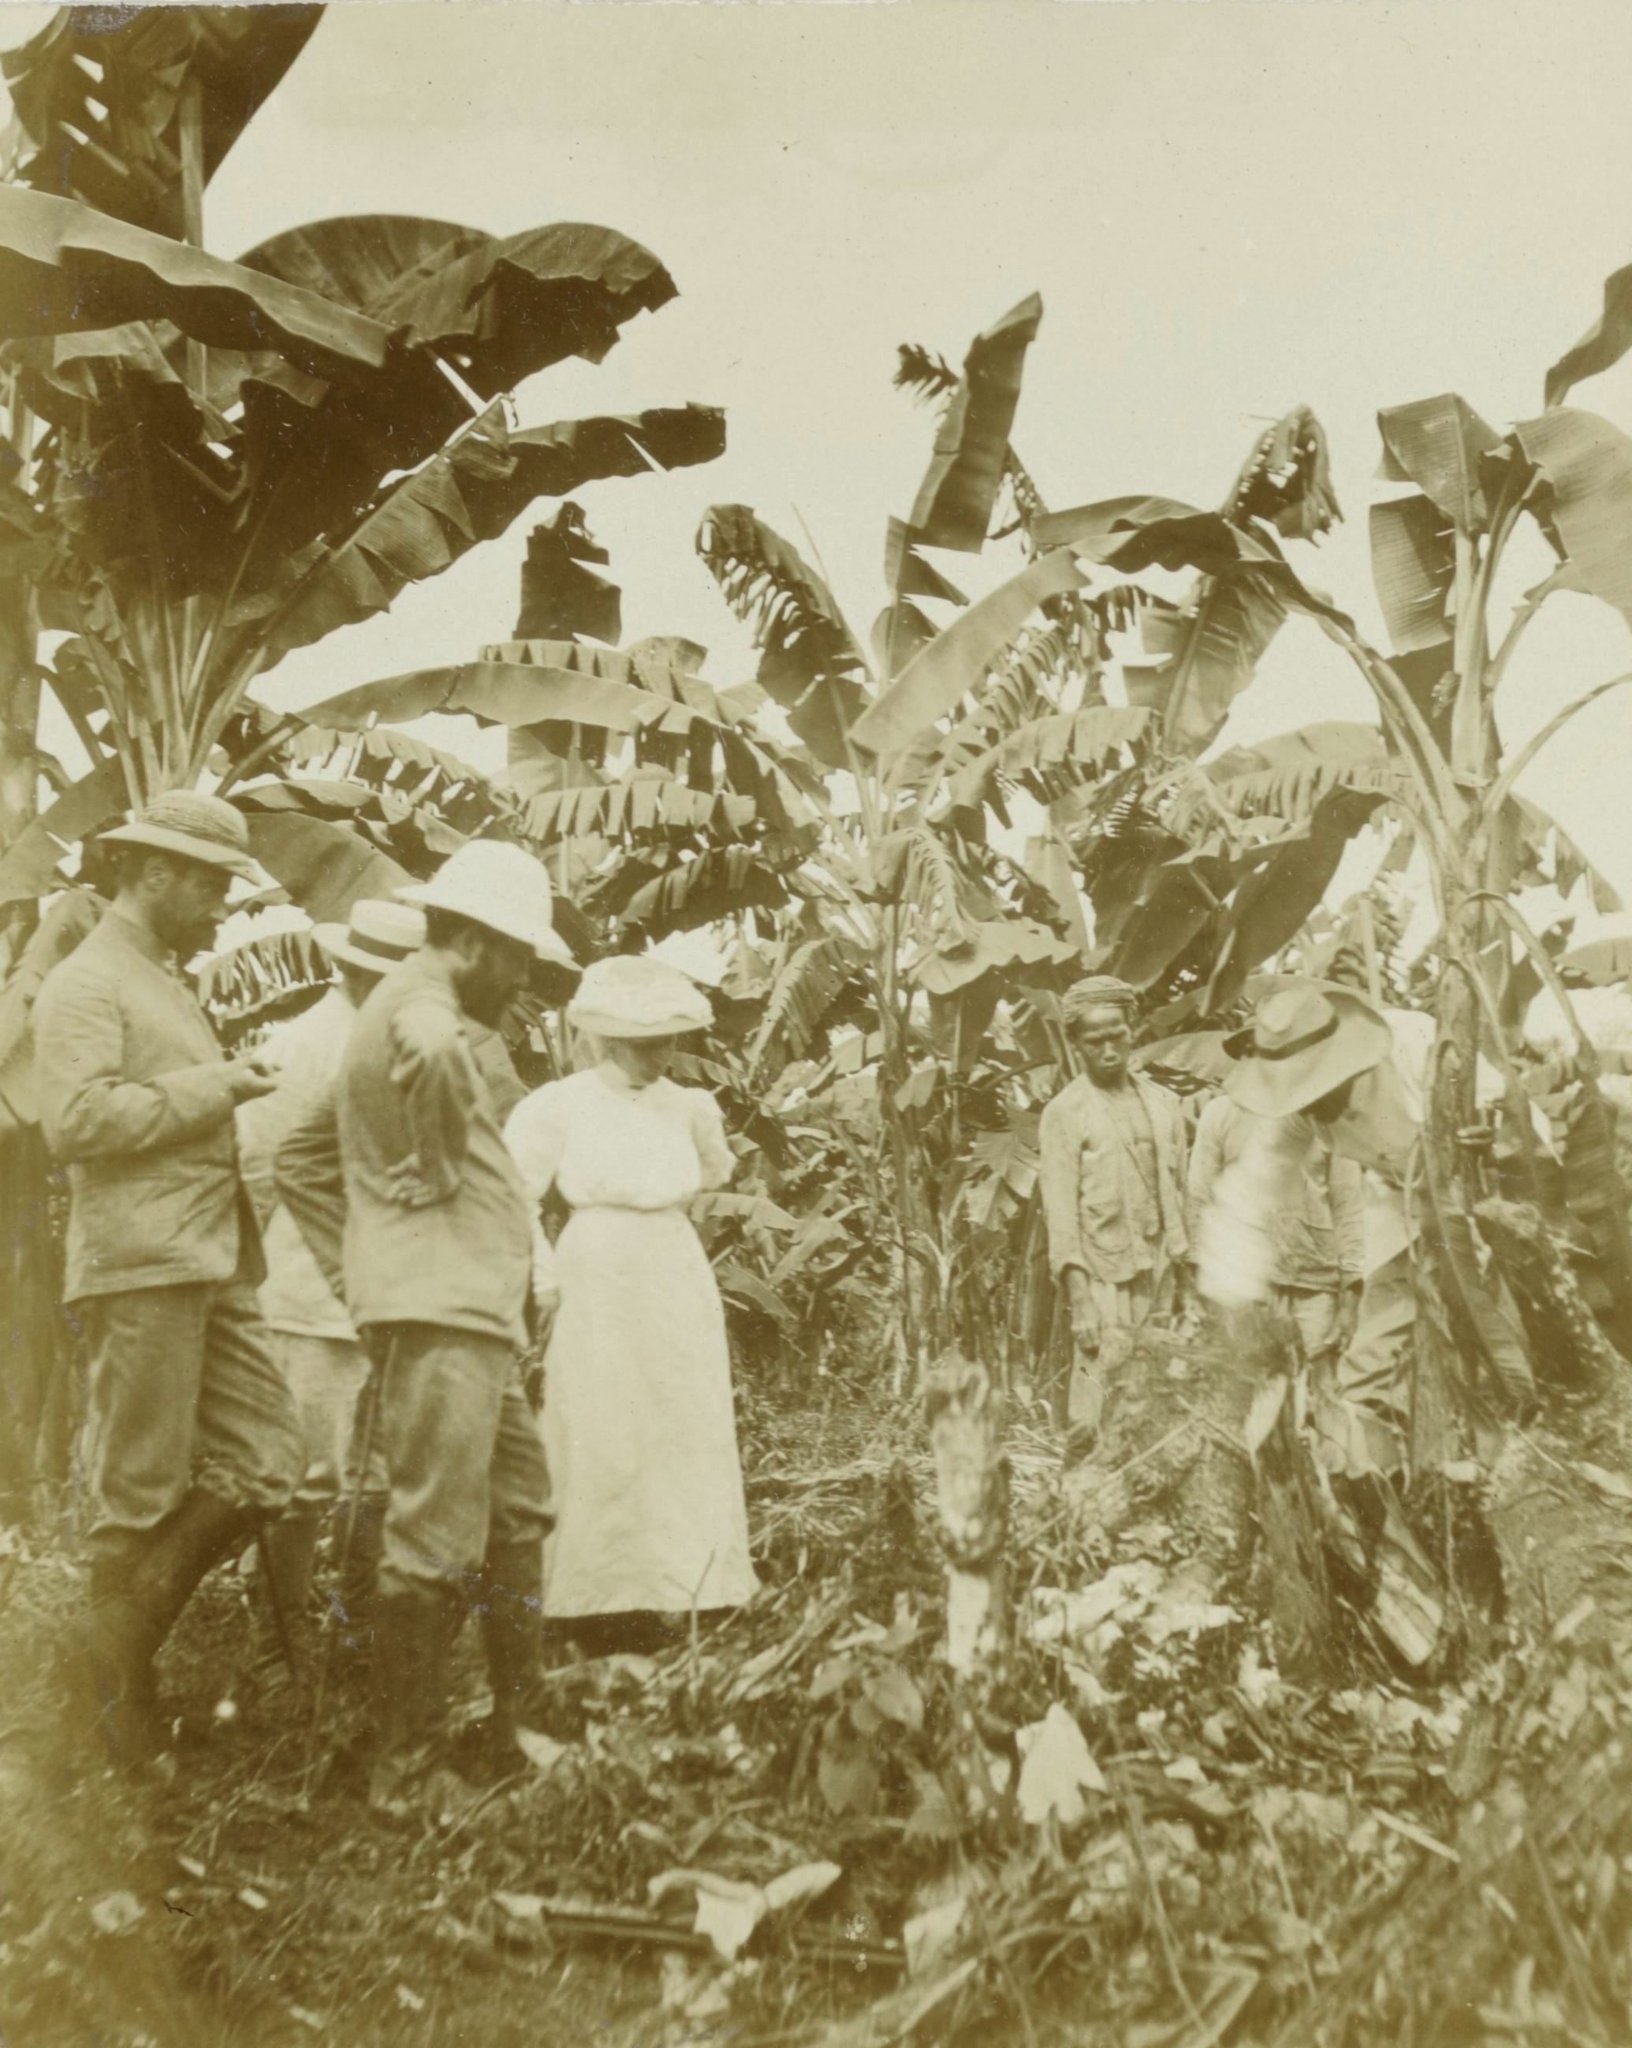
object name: photograph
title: Plantage La Liberté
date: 1908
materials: photographic support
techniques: photography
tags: plantation, fruits: banana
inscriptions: inscription: ‘Mr vd Werk / Drost / Dr. v. Hall / ... / Plantage "Liberté" Aug. 1908. Bacovenplanten (De opzichter kapt er een aan)’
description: Dr. C.J.J. van Hall en enkele anderen onderzoeken bananenplanten op Plantage La Liberté, augustus 1908. Onderdeel van het fotoalbum van de familie Boom-Gonggrijp in Suriname en Curaçao.